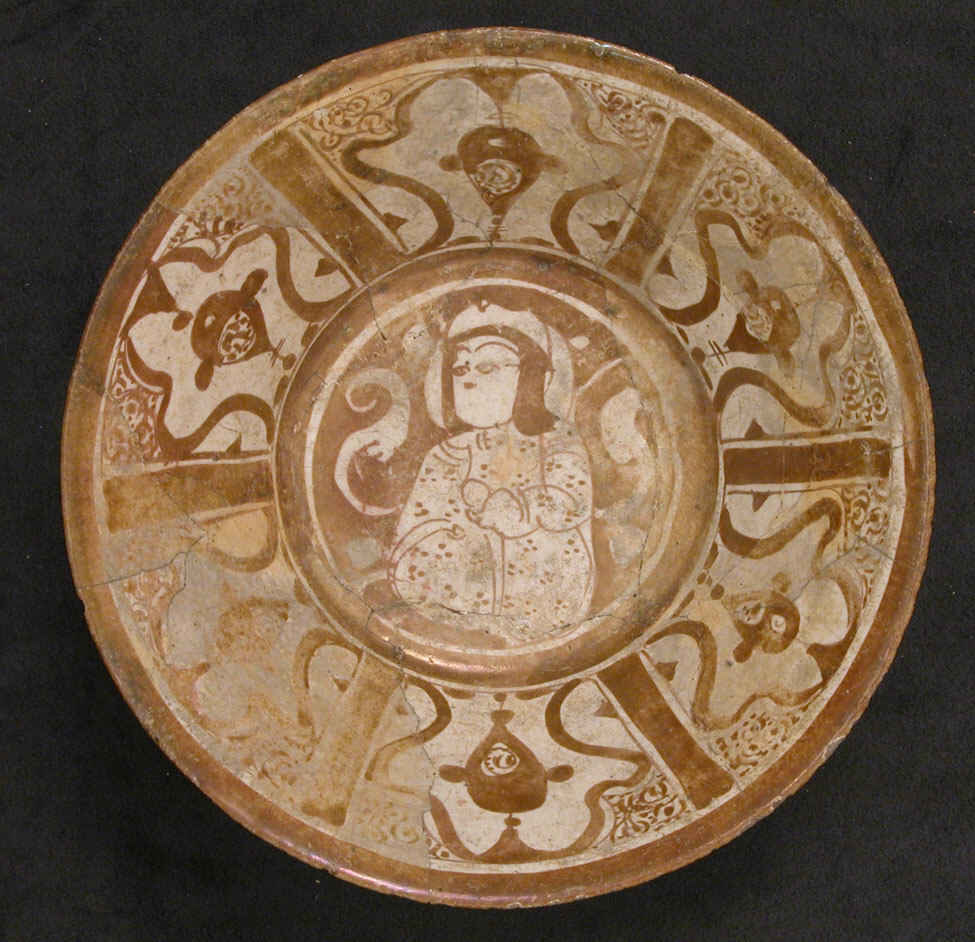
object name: bowl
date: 1101-1300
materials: glaze, stonepaste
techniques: luster painting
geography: iran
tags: human figures